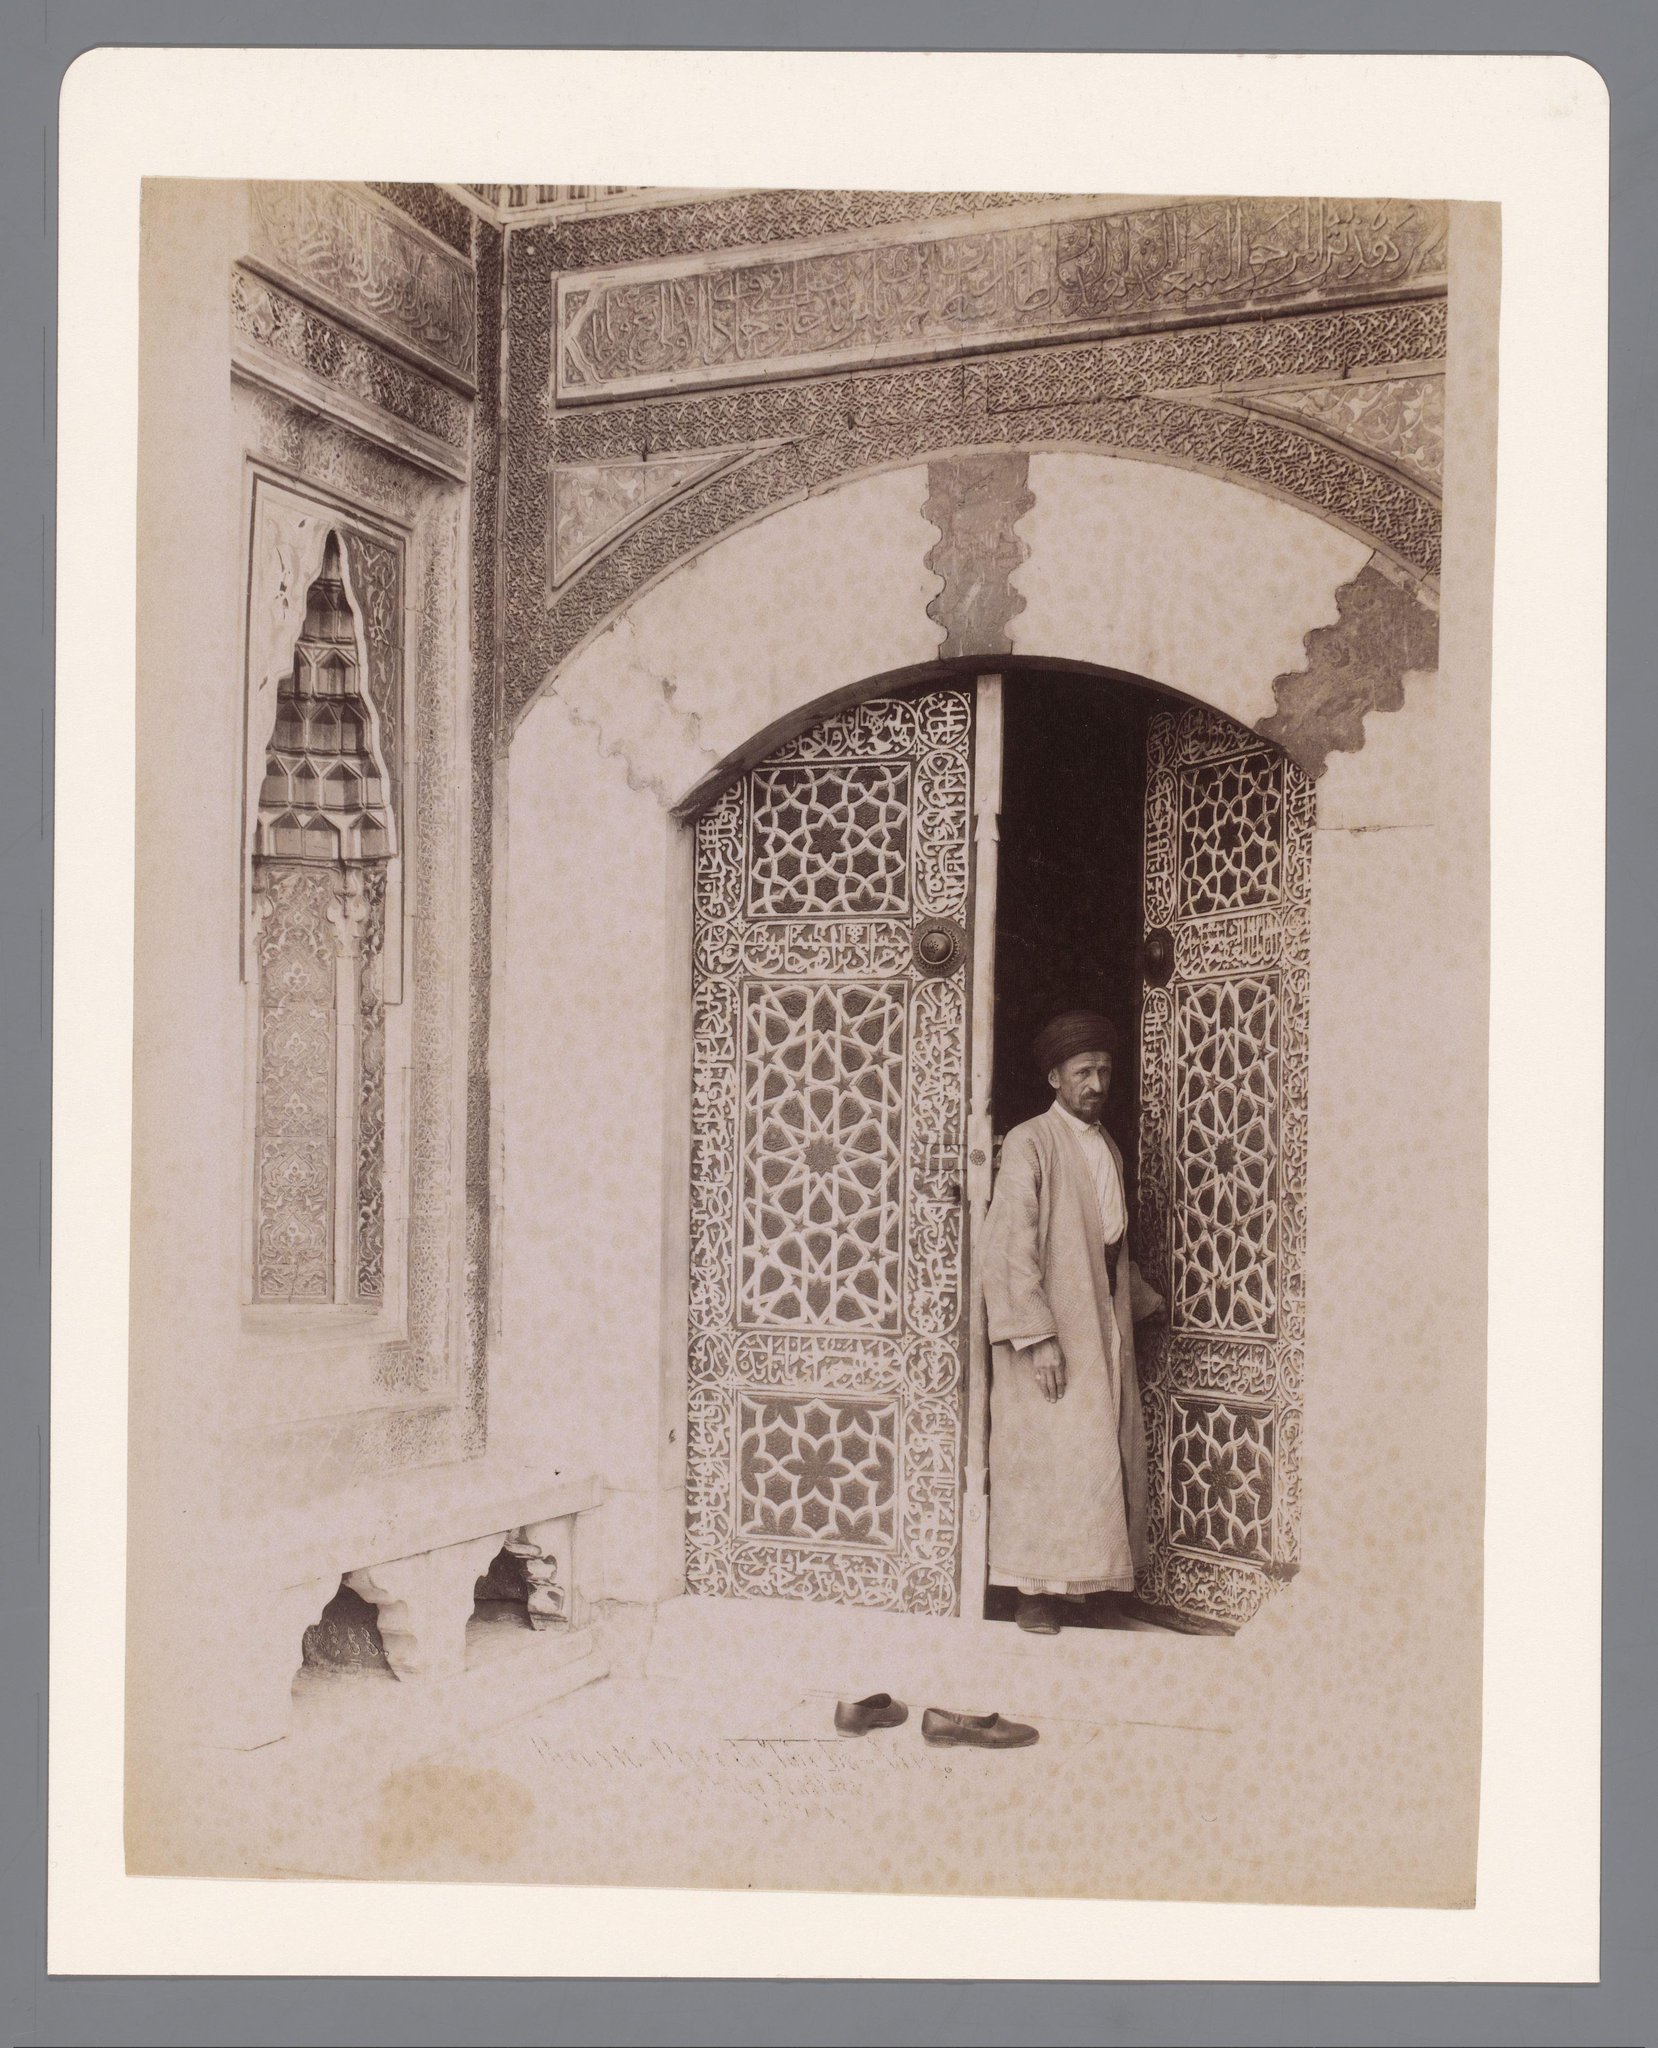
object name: photograph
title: Onbekende man in de deuropening van een moskee, mogelijk in Turkije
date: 1888-1900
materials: paper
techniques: albumen print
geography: turkey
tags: temple, shrine ~ islam, mohammedanism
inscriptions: inscription: ‘[onleesbaar]’